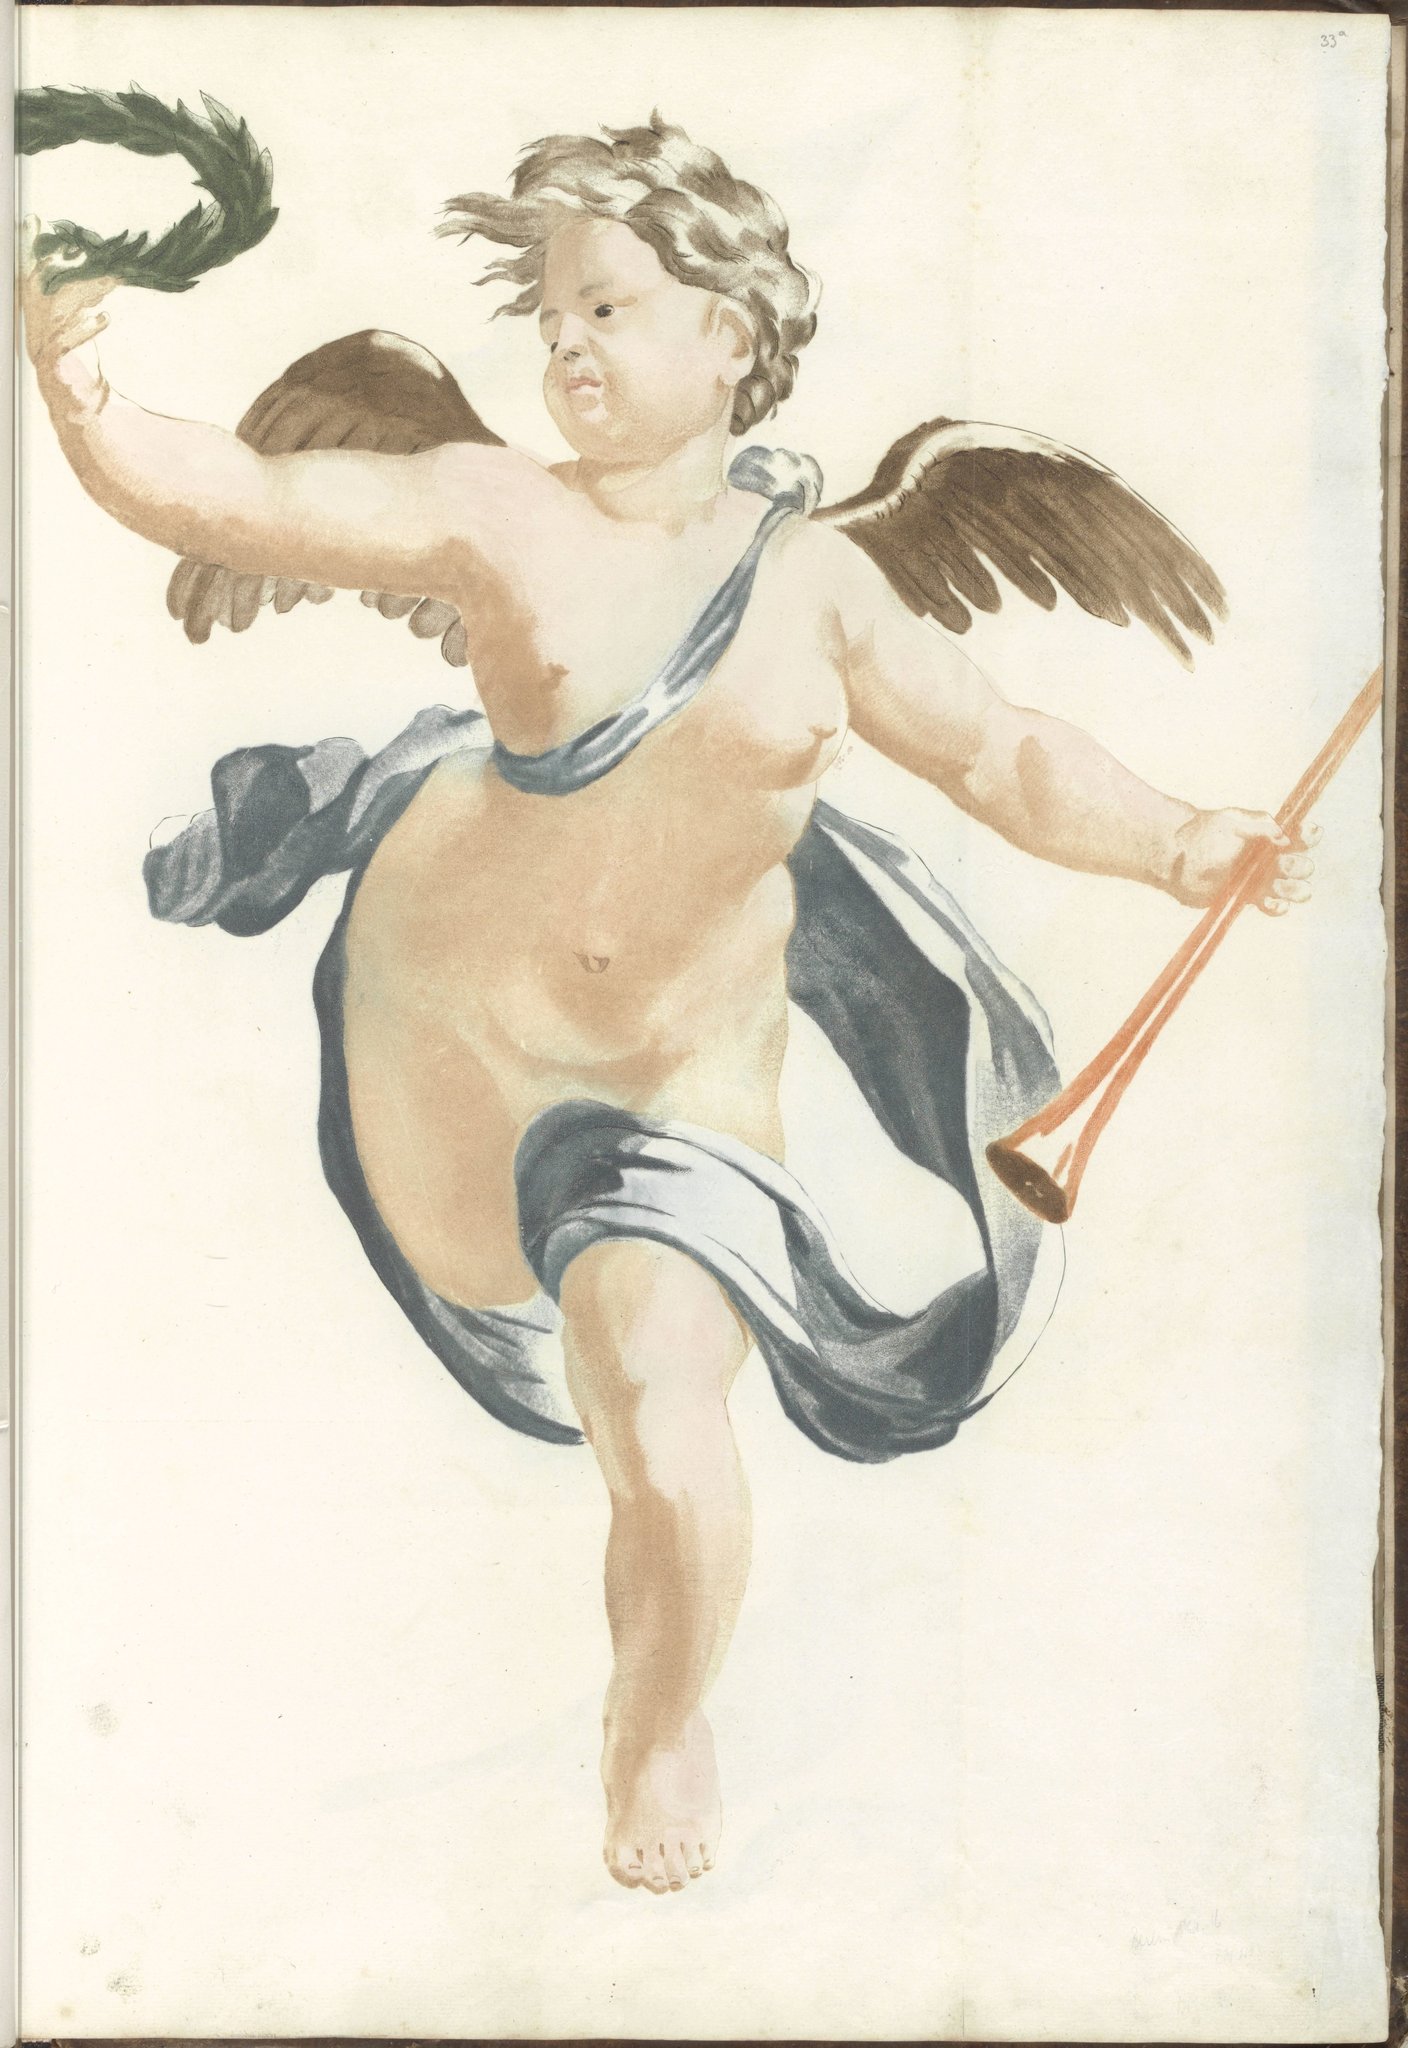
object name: print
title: Putto met lauwerkrans en loftrompet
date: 1688-1698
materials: paper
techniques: printing, drypoint, engraving, roulette, lithography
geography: netherlands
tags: crowning with laurel, fame; 'fama', 'fama buona', 'fama chiara' (ripa), cupids: 'amores', 'amoretti', 'putti'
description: Putto, met lauwerkrans en loftrompet in de handen. Wellicht een personificatie van de faam. Deze prent maakt deel uit van een album.